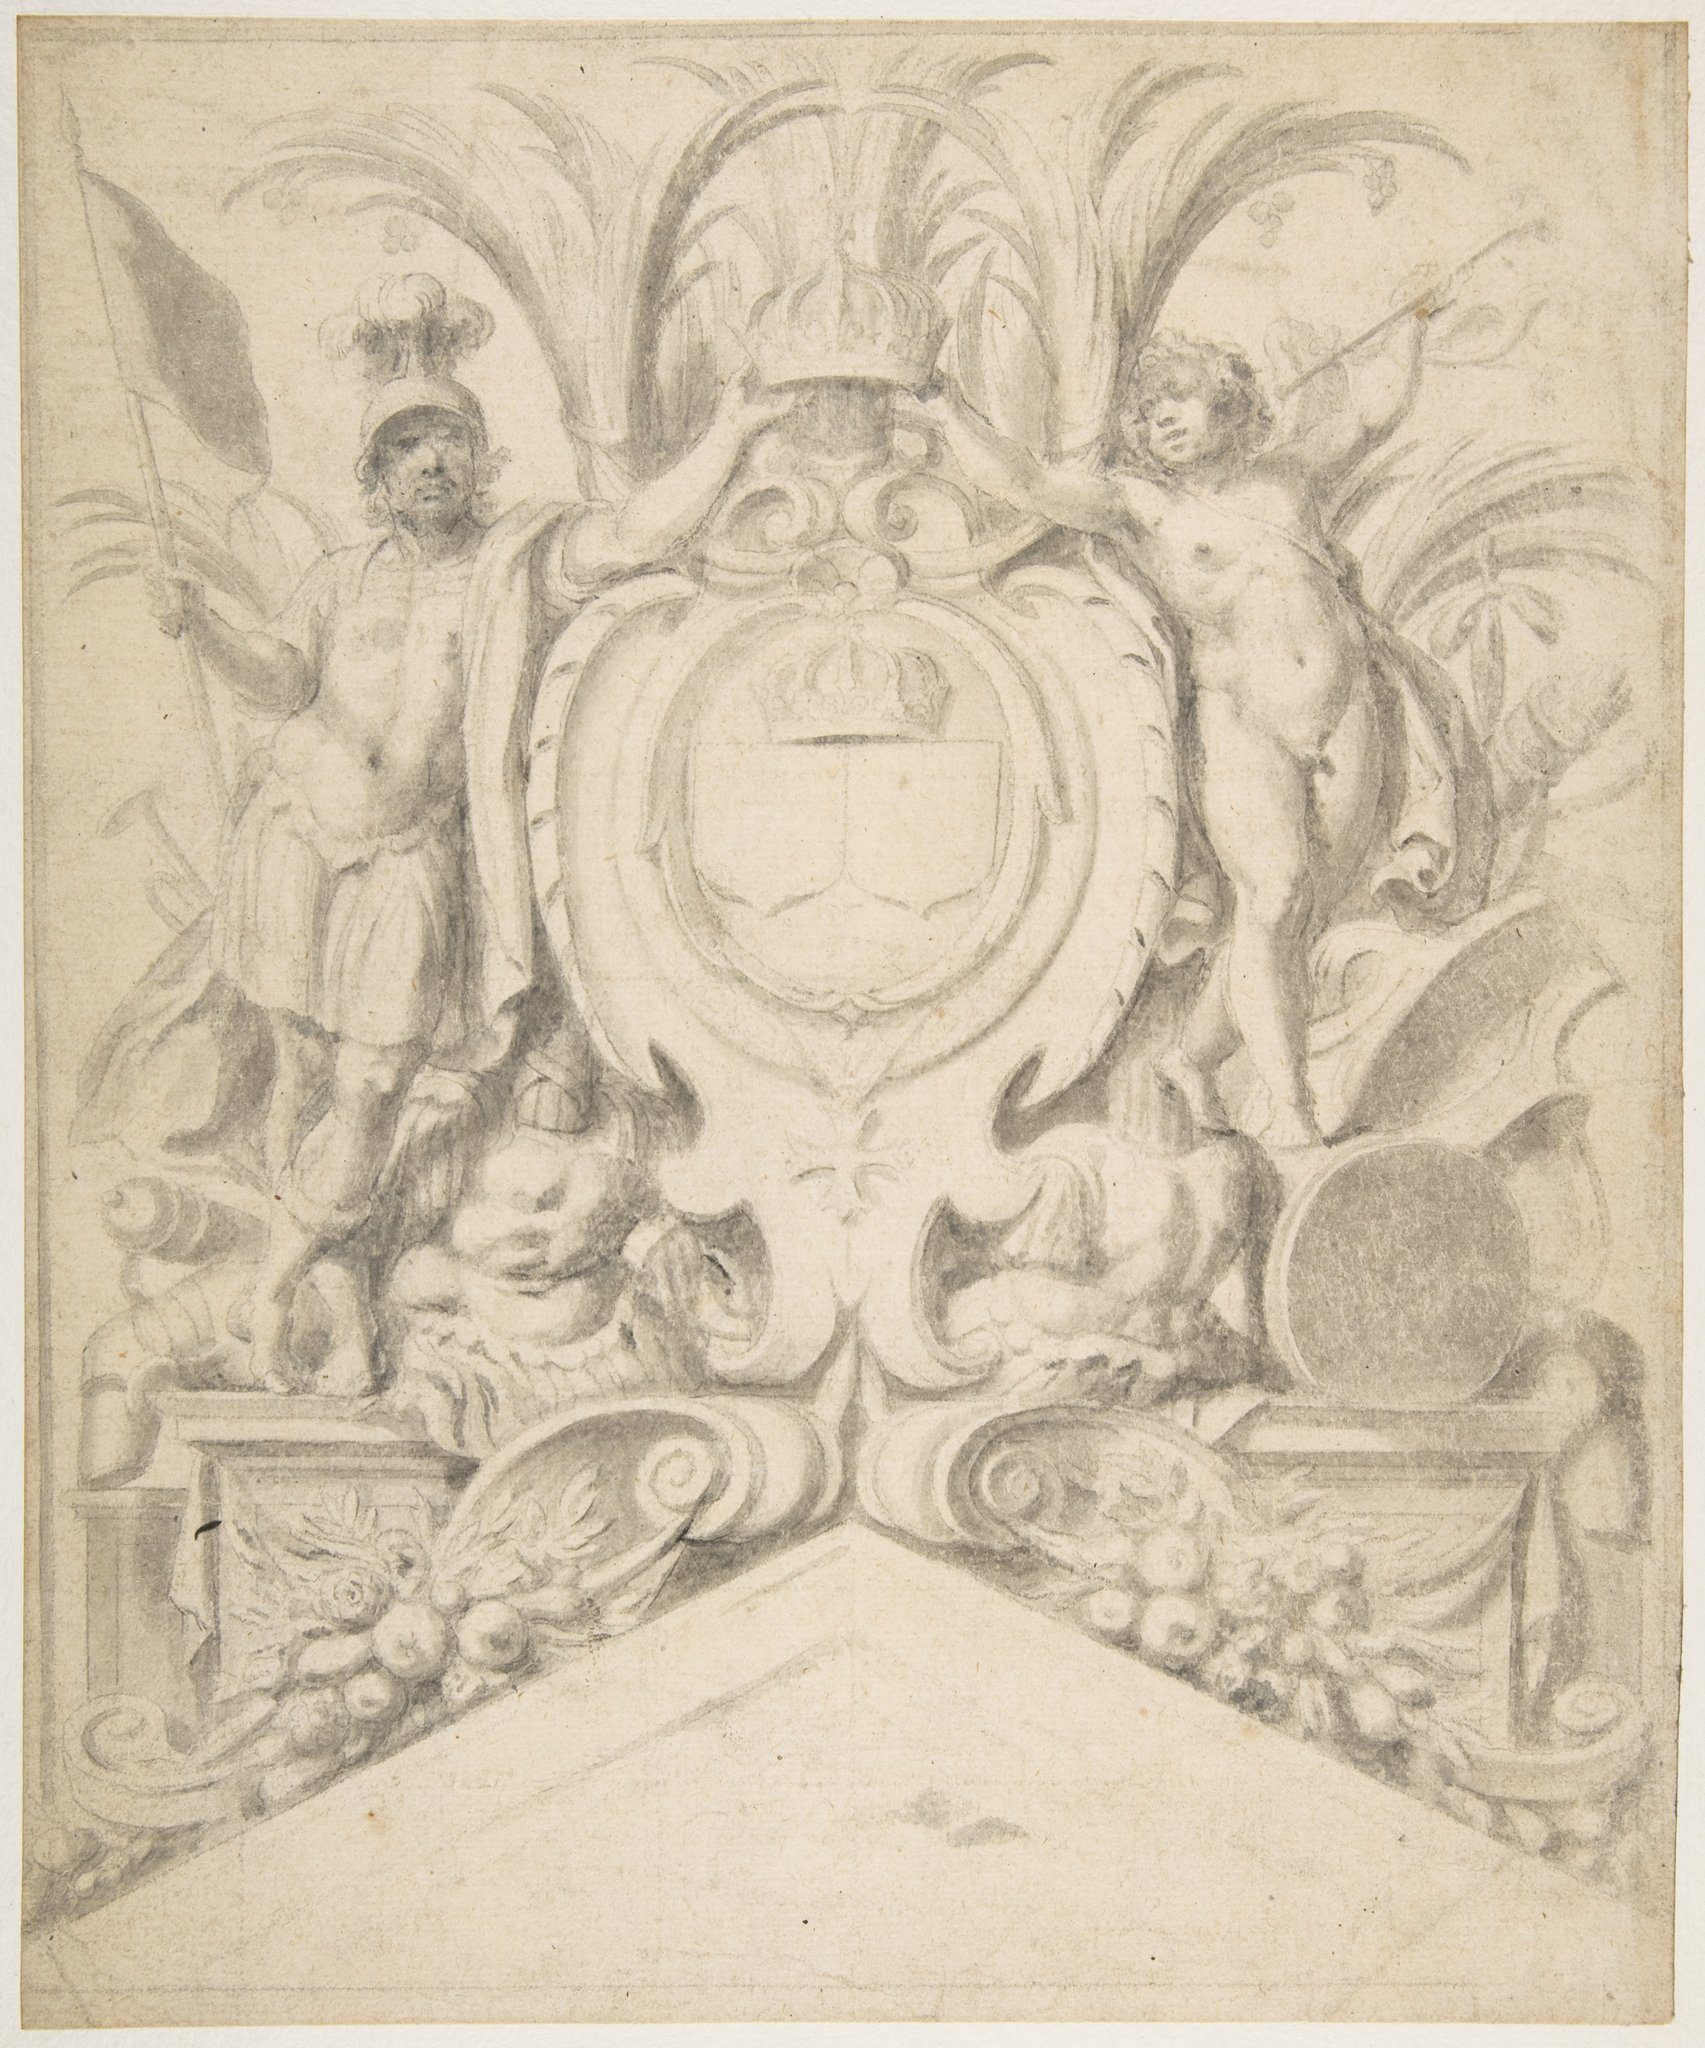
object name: drawing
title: Design for an Overdoor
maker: anonymous, french, 17th century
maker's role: artist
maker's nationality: french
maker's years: 1600-1700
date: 1640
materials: ink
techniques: brush, pen, wash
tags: coat of arms